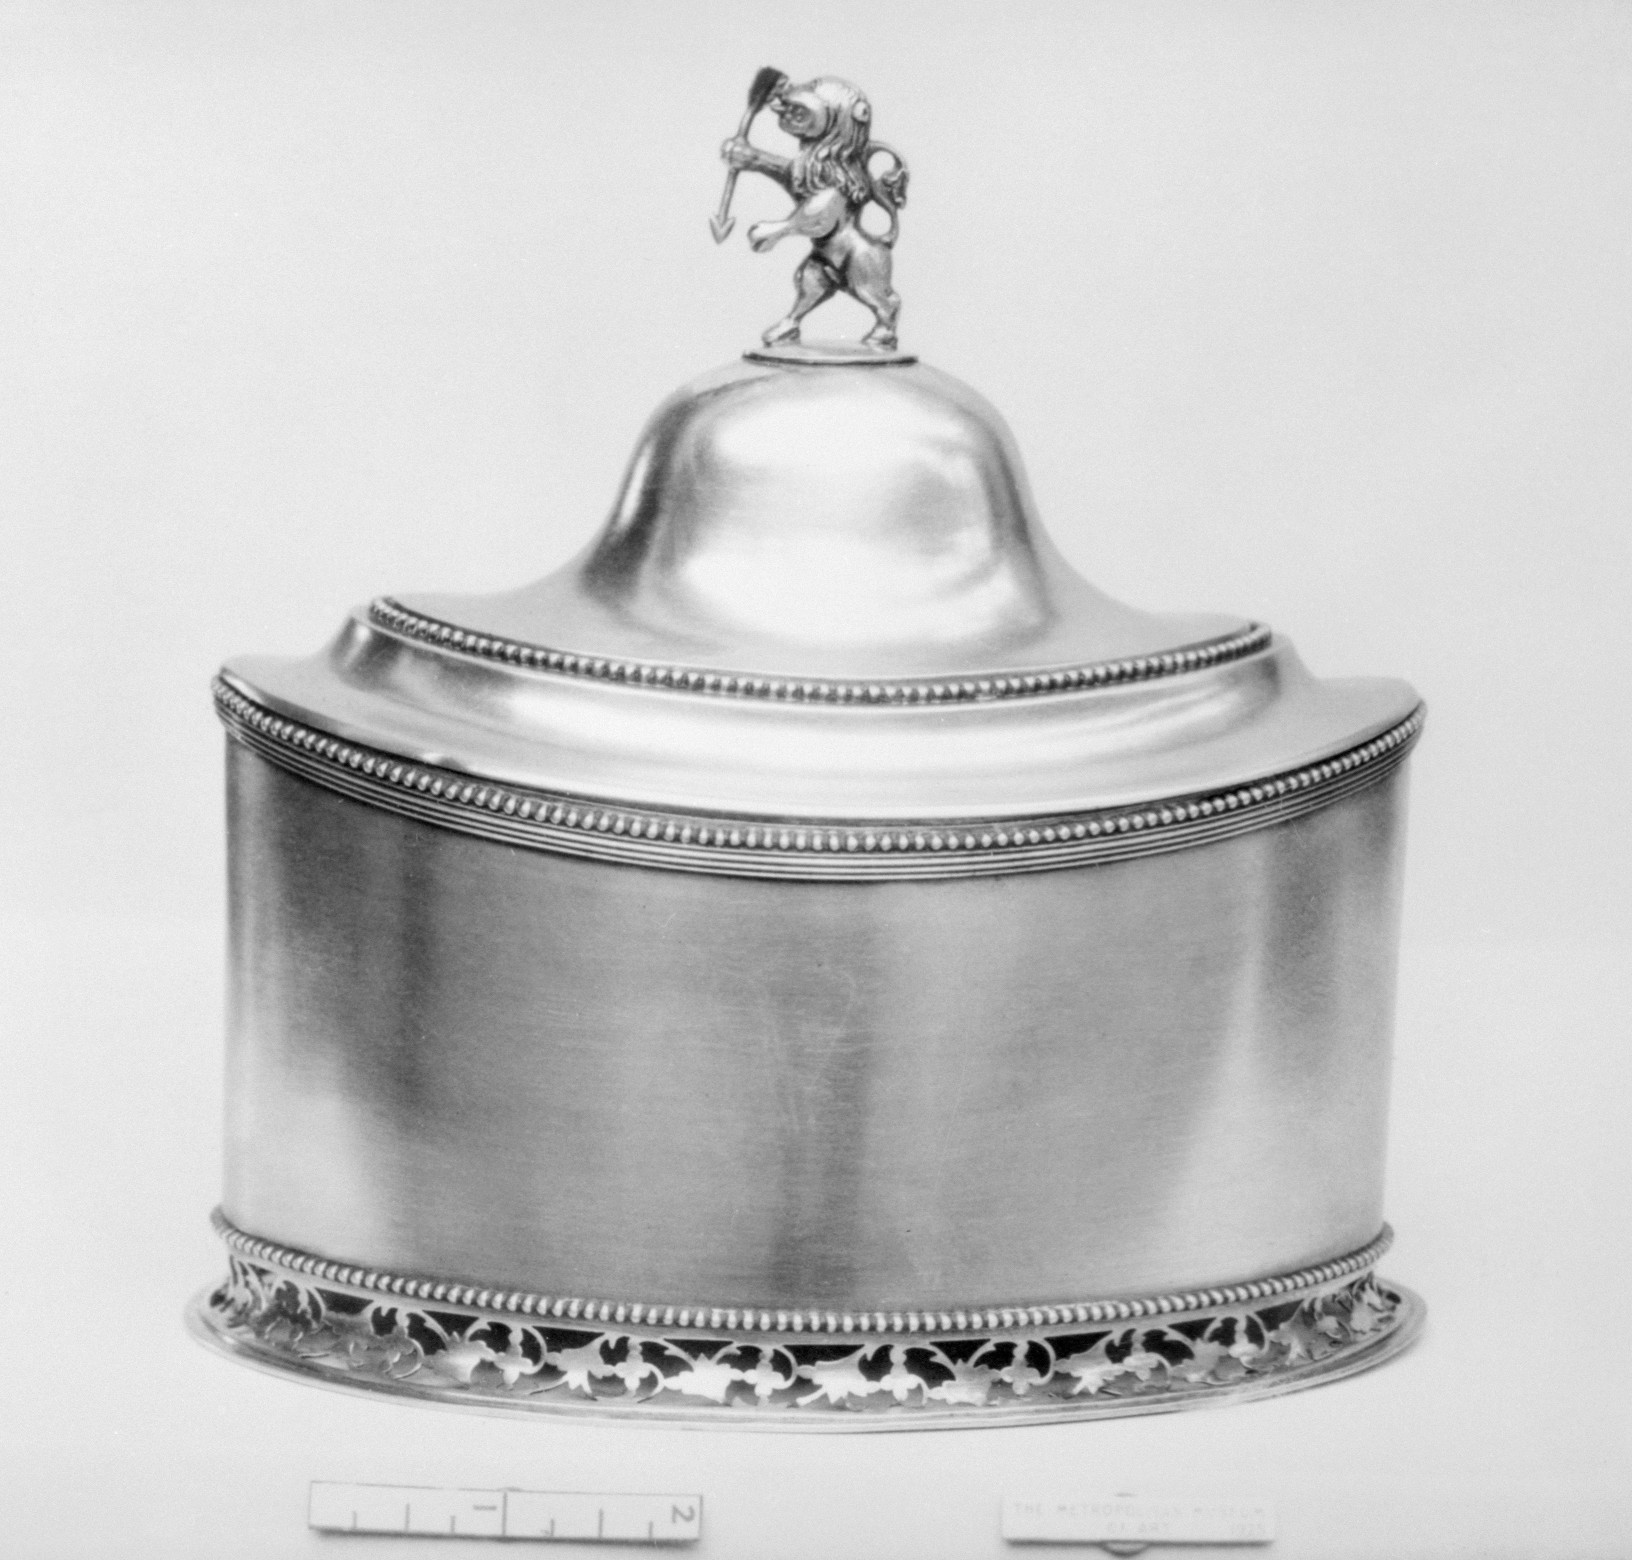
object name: tea caddy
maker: d. w. rehtmeier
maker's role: maker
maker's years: 1750-1850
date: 1807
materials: silver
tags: lions